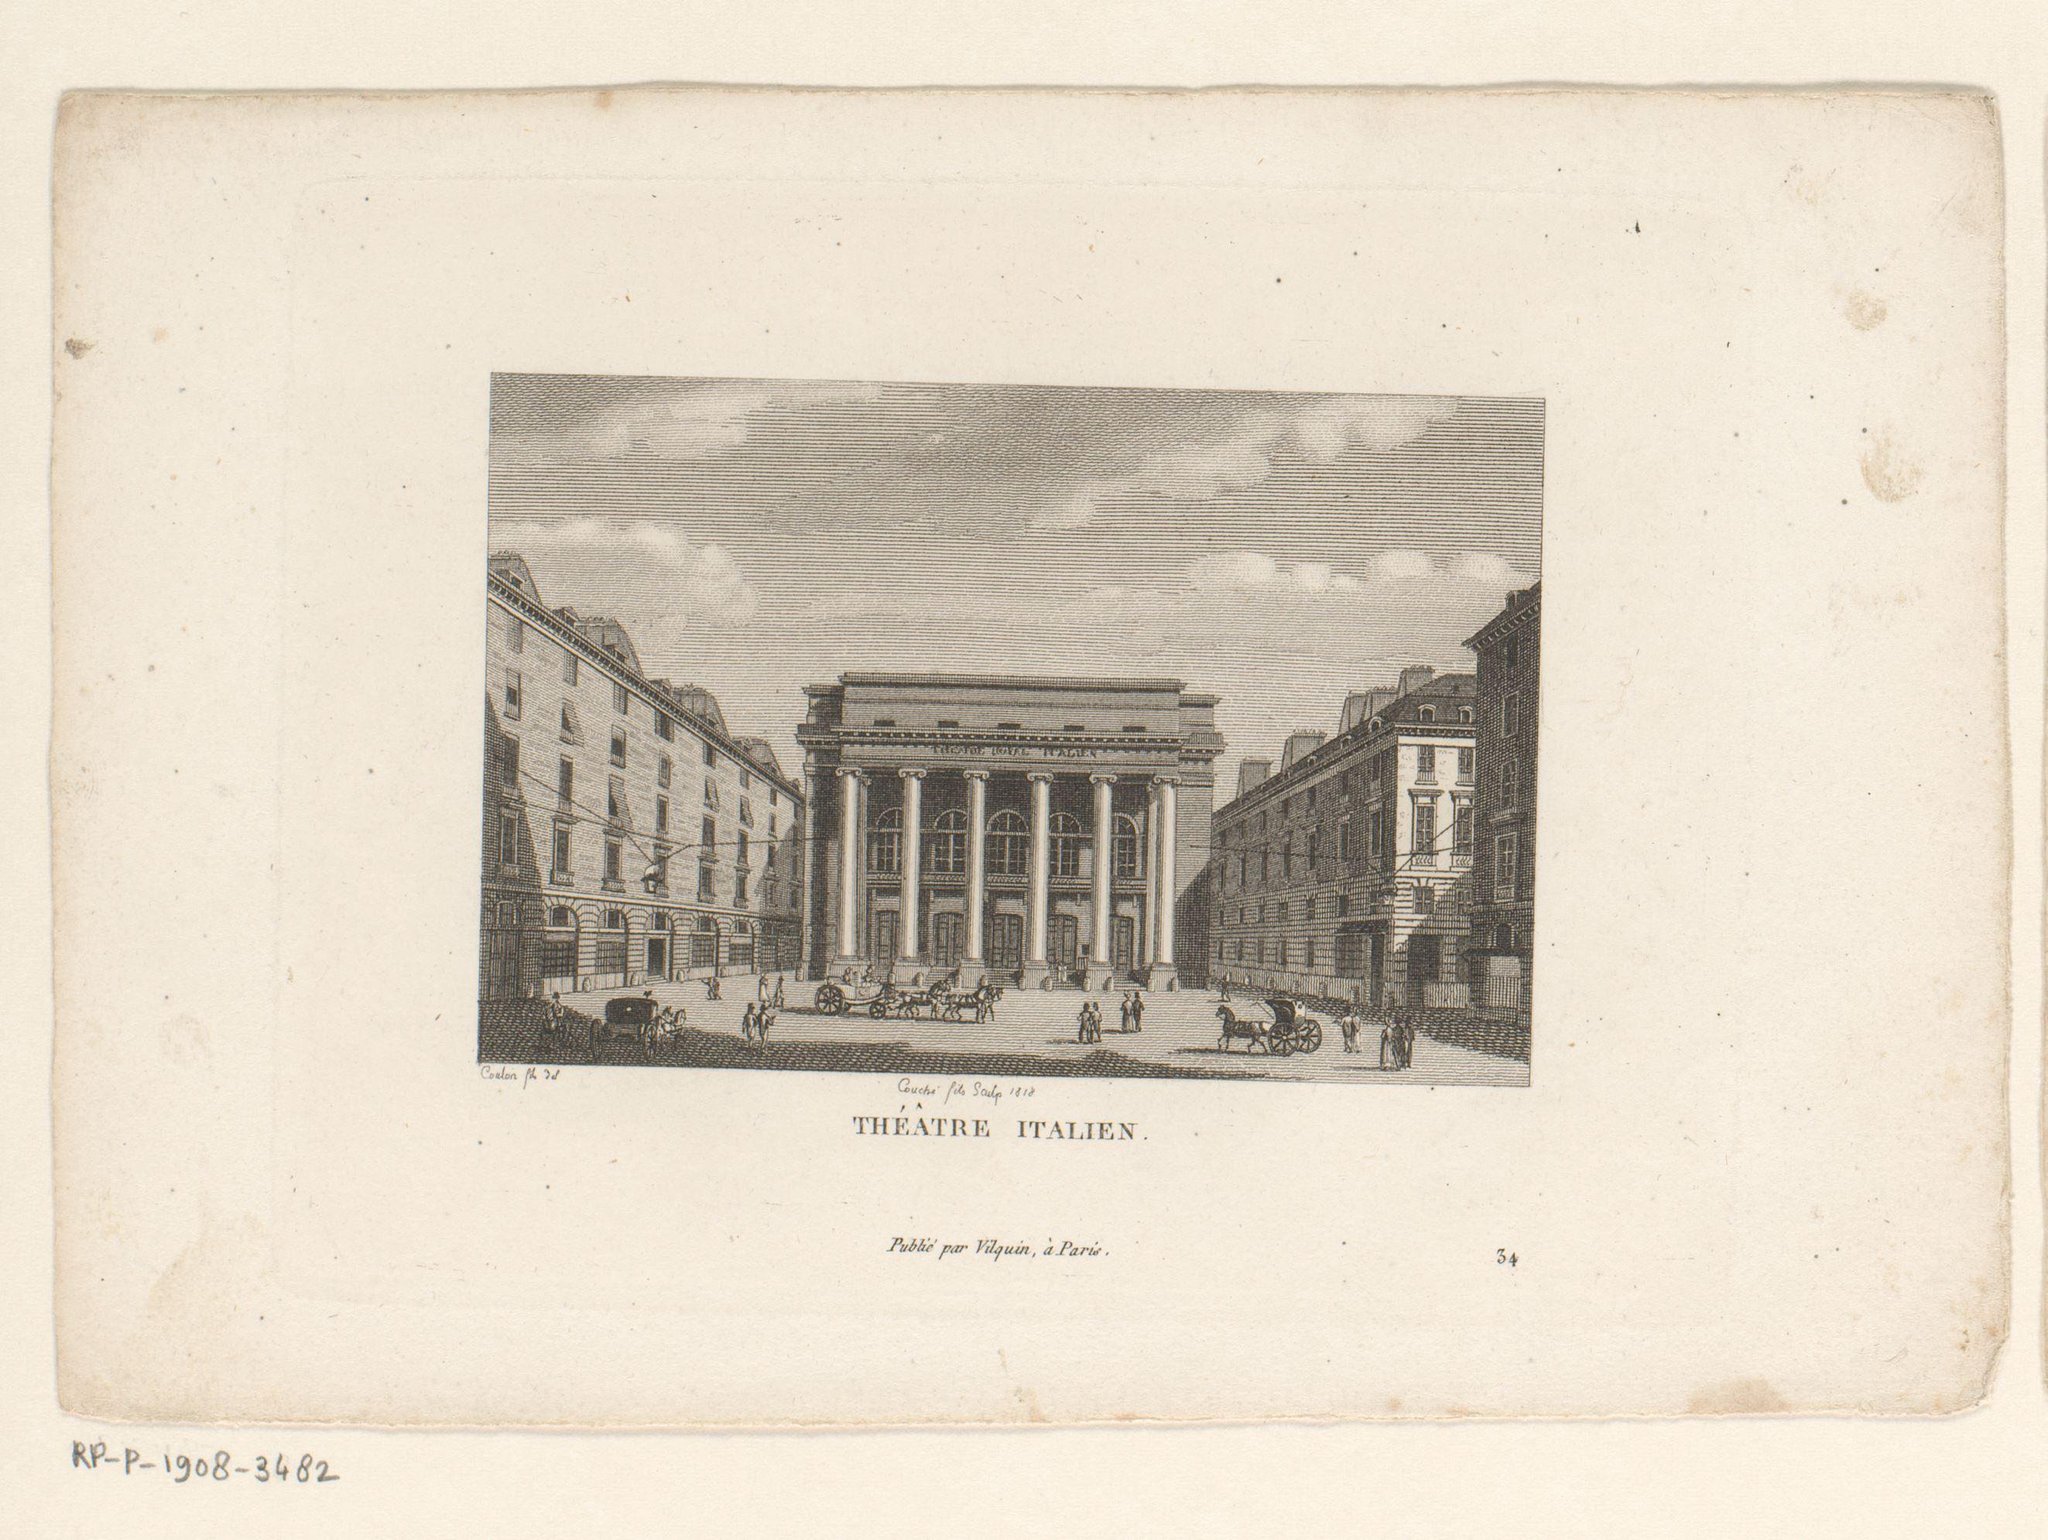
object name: print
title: Théàtre Italien.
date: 1818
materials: paper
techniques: etching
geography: paris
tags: city-view in general; 'veduta', theatre (building), paris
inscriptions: collector's mark: Lugt 2228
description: Maakt deel uit van een serie met 60 platen van monumenten, kathedralen en paleizen in Parijs.